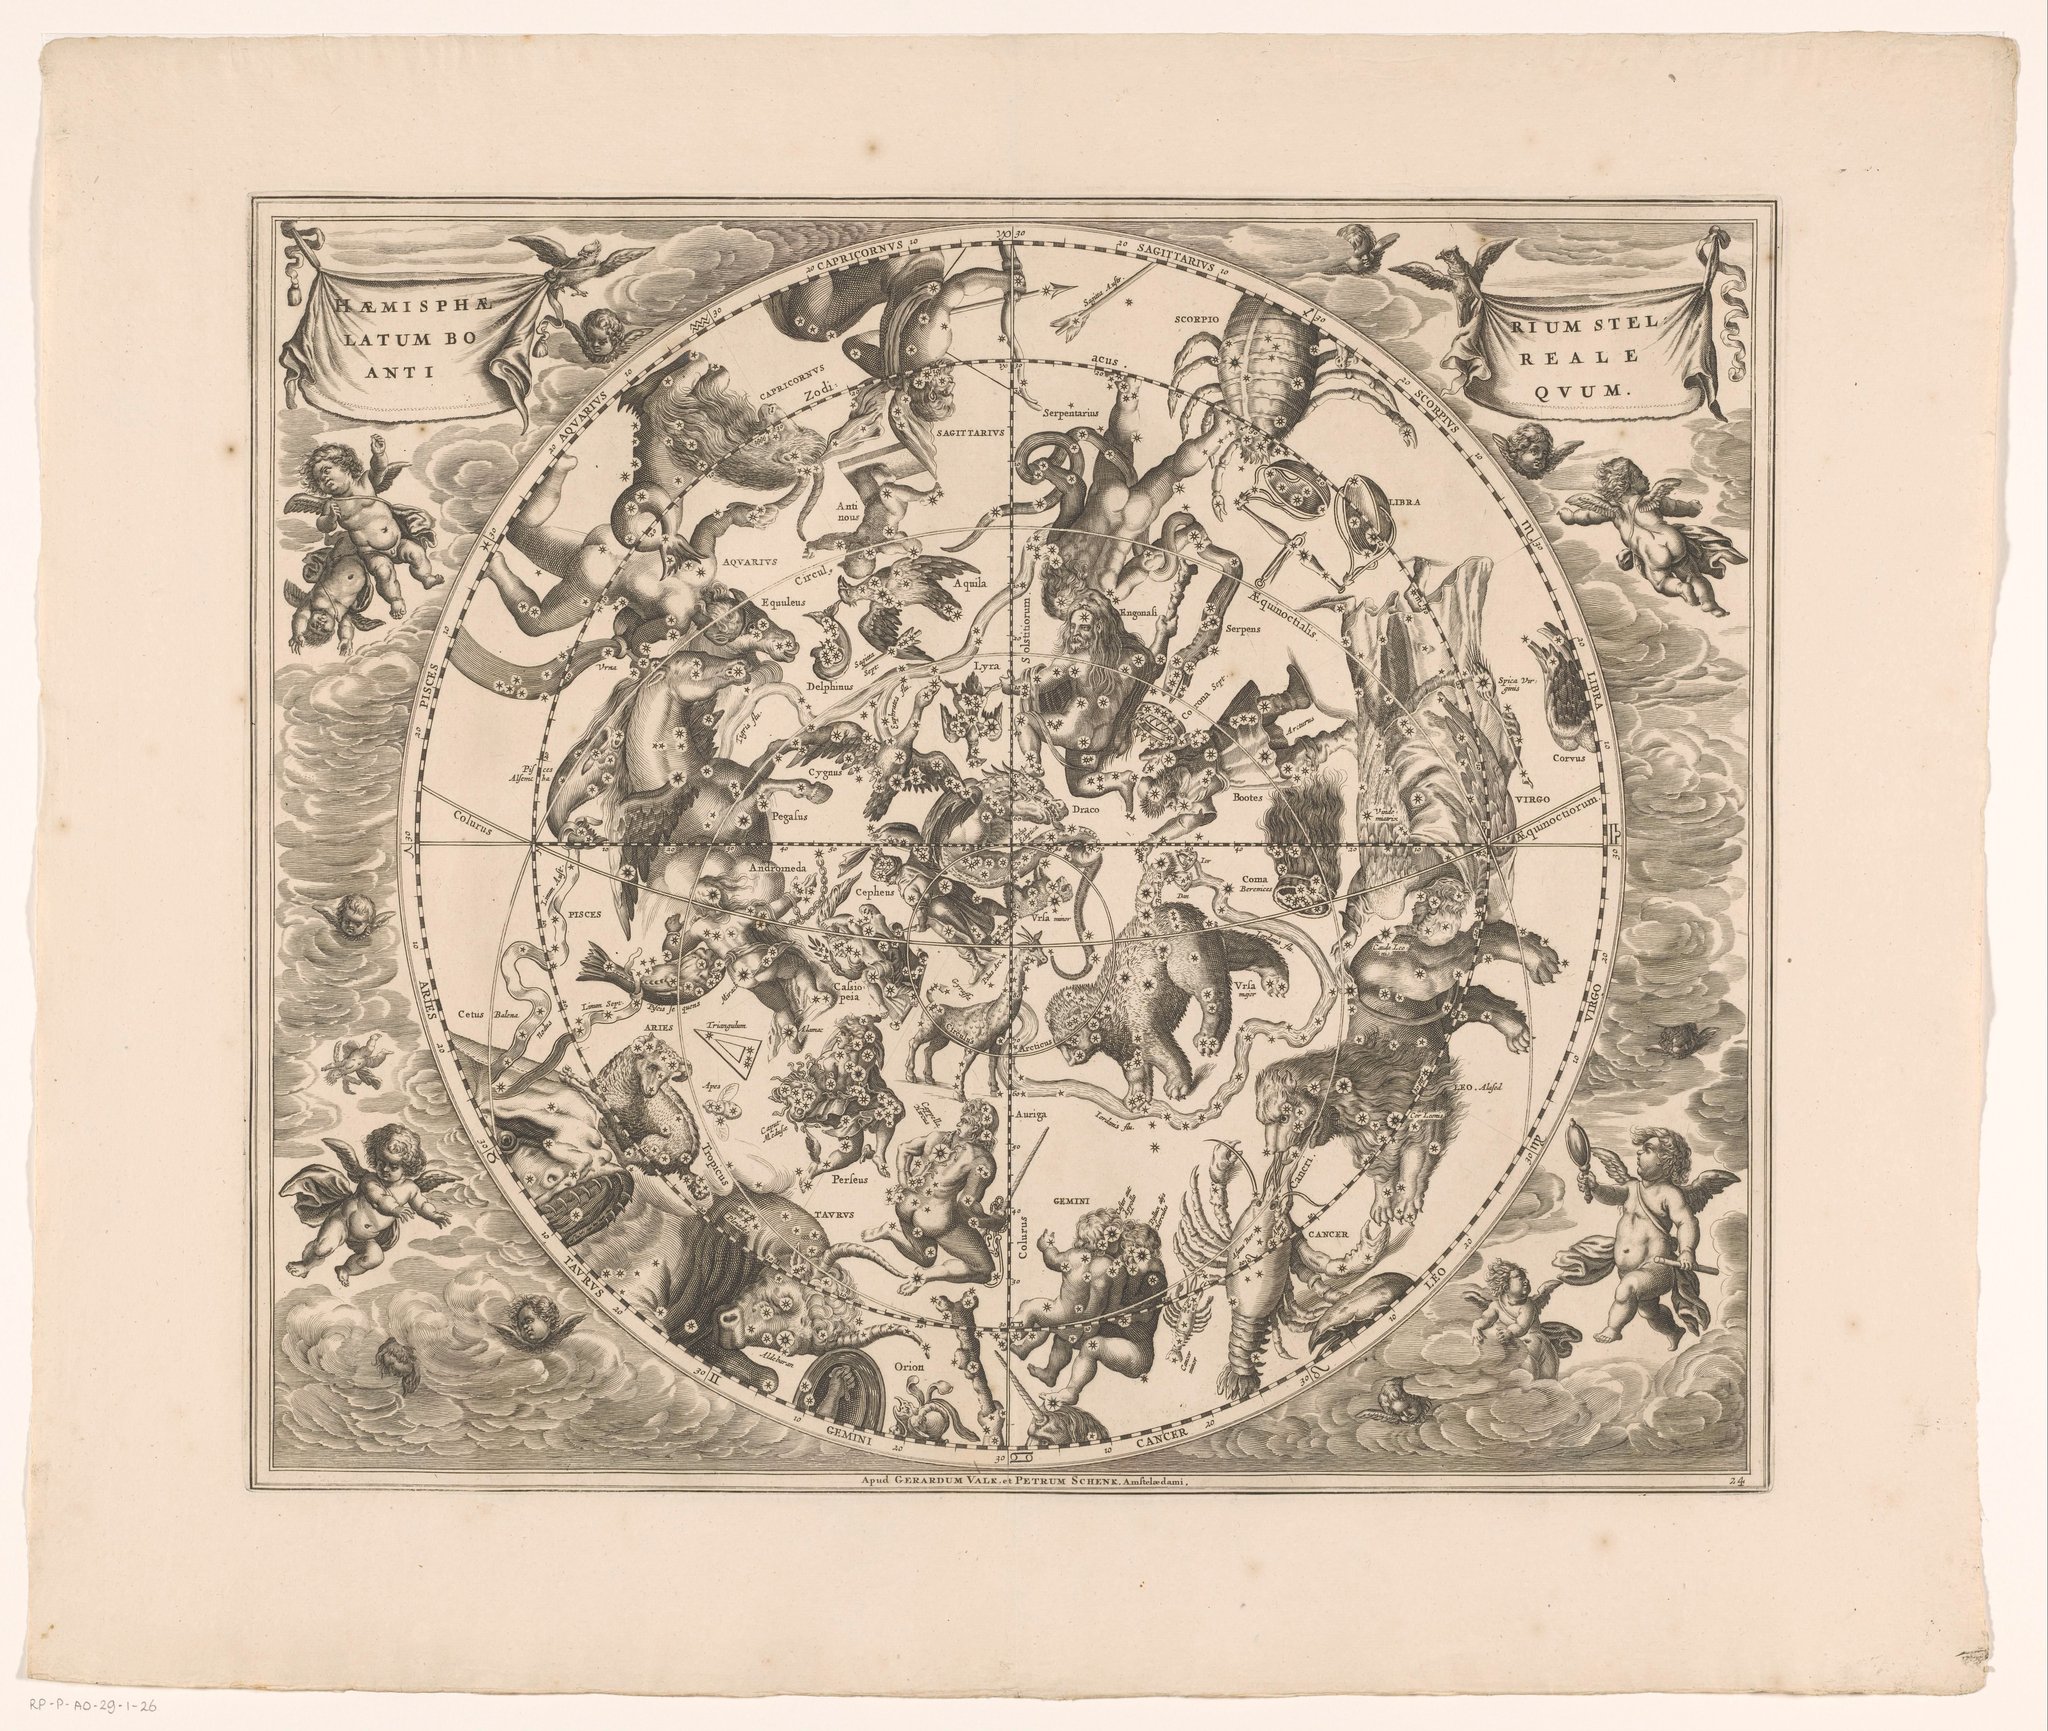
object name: print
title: Haemisphaerium stellatum boreale antiquum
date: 1660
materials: paper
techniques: engraving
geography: amsterdam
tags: zodiac; the twelve zodiacal signs together, star-chart, star map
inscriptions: collector's mark: Lugt 2228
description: Prent ook gebruikt in: Cellarius, Andreas. Harmonia Macrocosmica seu Atlas Universalis et Novus. Amsterdam: Pieter Schenk (I) en Gerard Valck, 1708. Zie ook: Gent, Rob van. De hemelatlas van Andreas Cellarius: het meesterwerk van een vergeten Hollandse kosmograaf. In: Caert-Thresoor, jaargang 19, nr. 1, 2000.